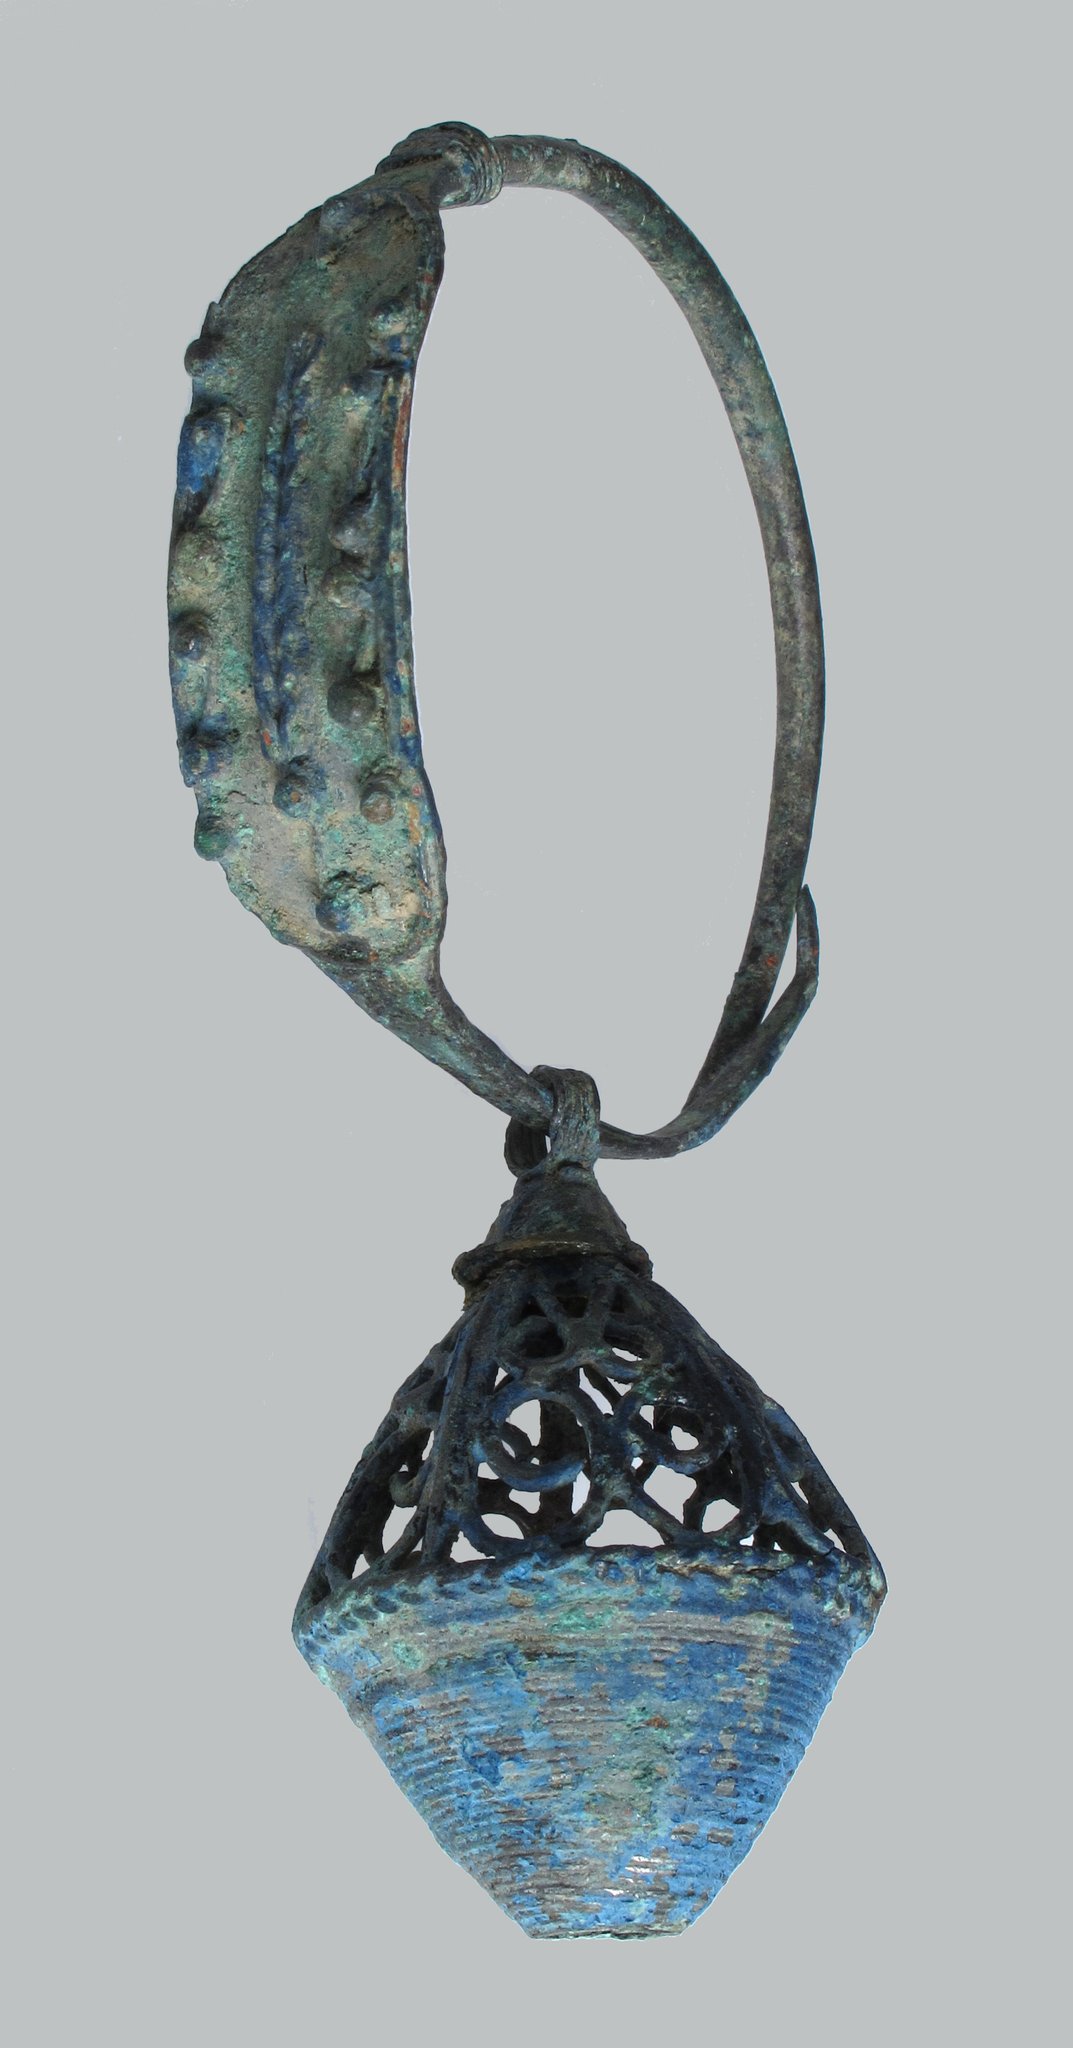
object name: earring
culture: avar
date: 701-900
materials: copper alloy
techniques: filigree